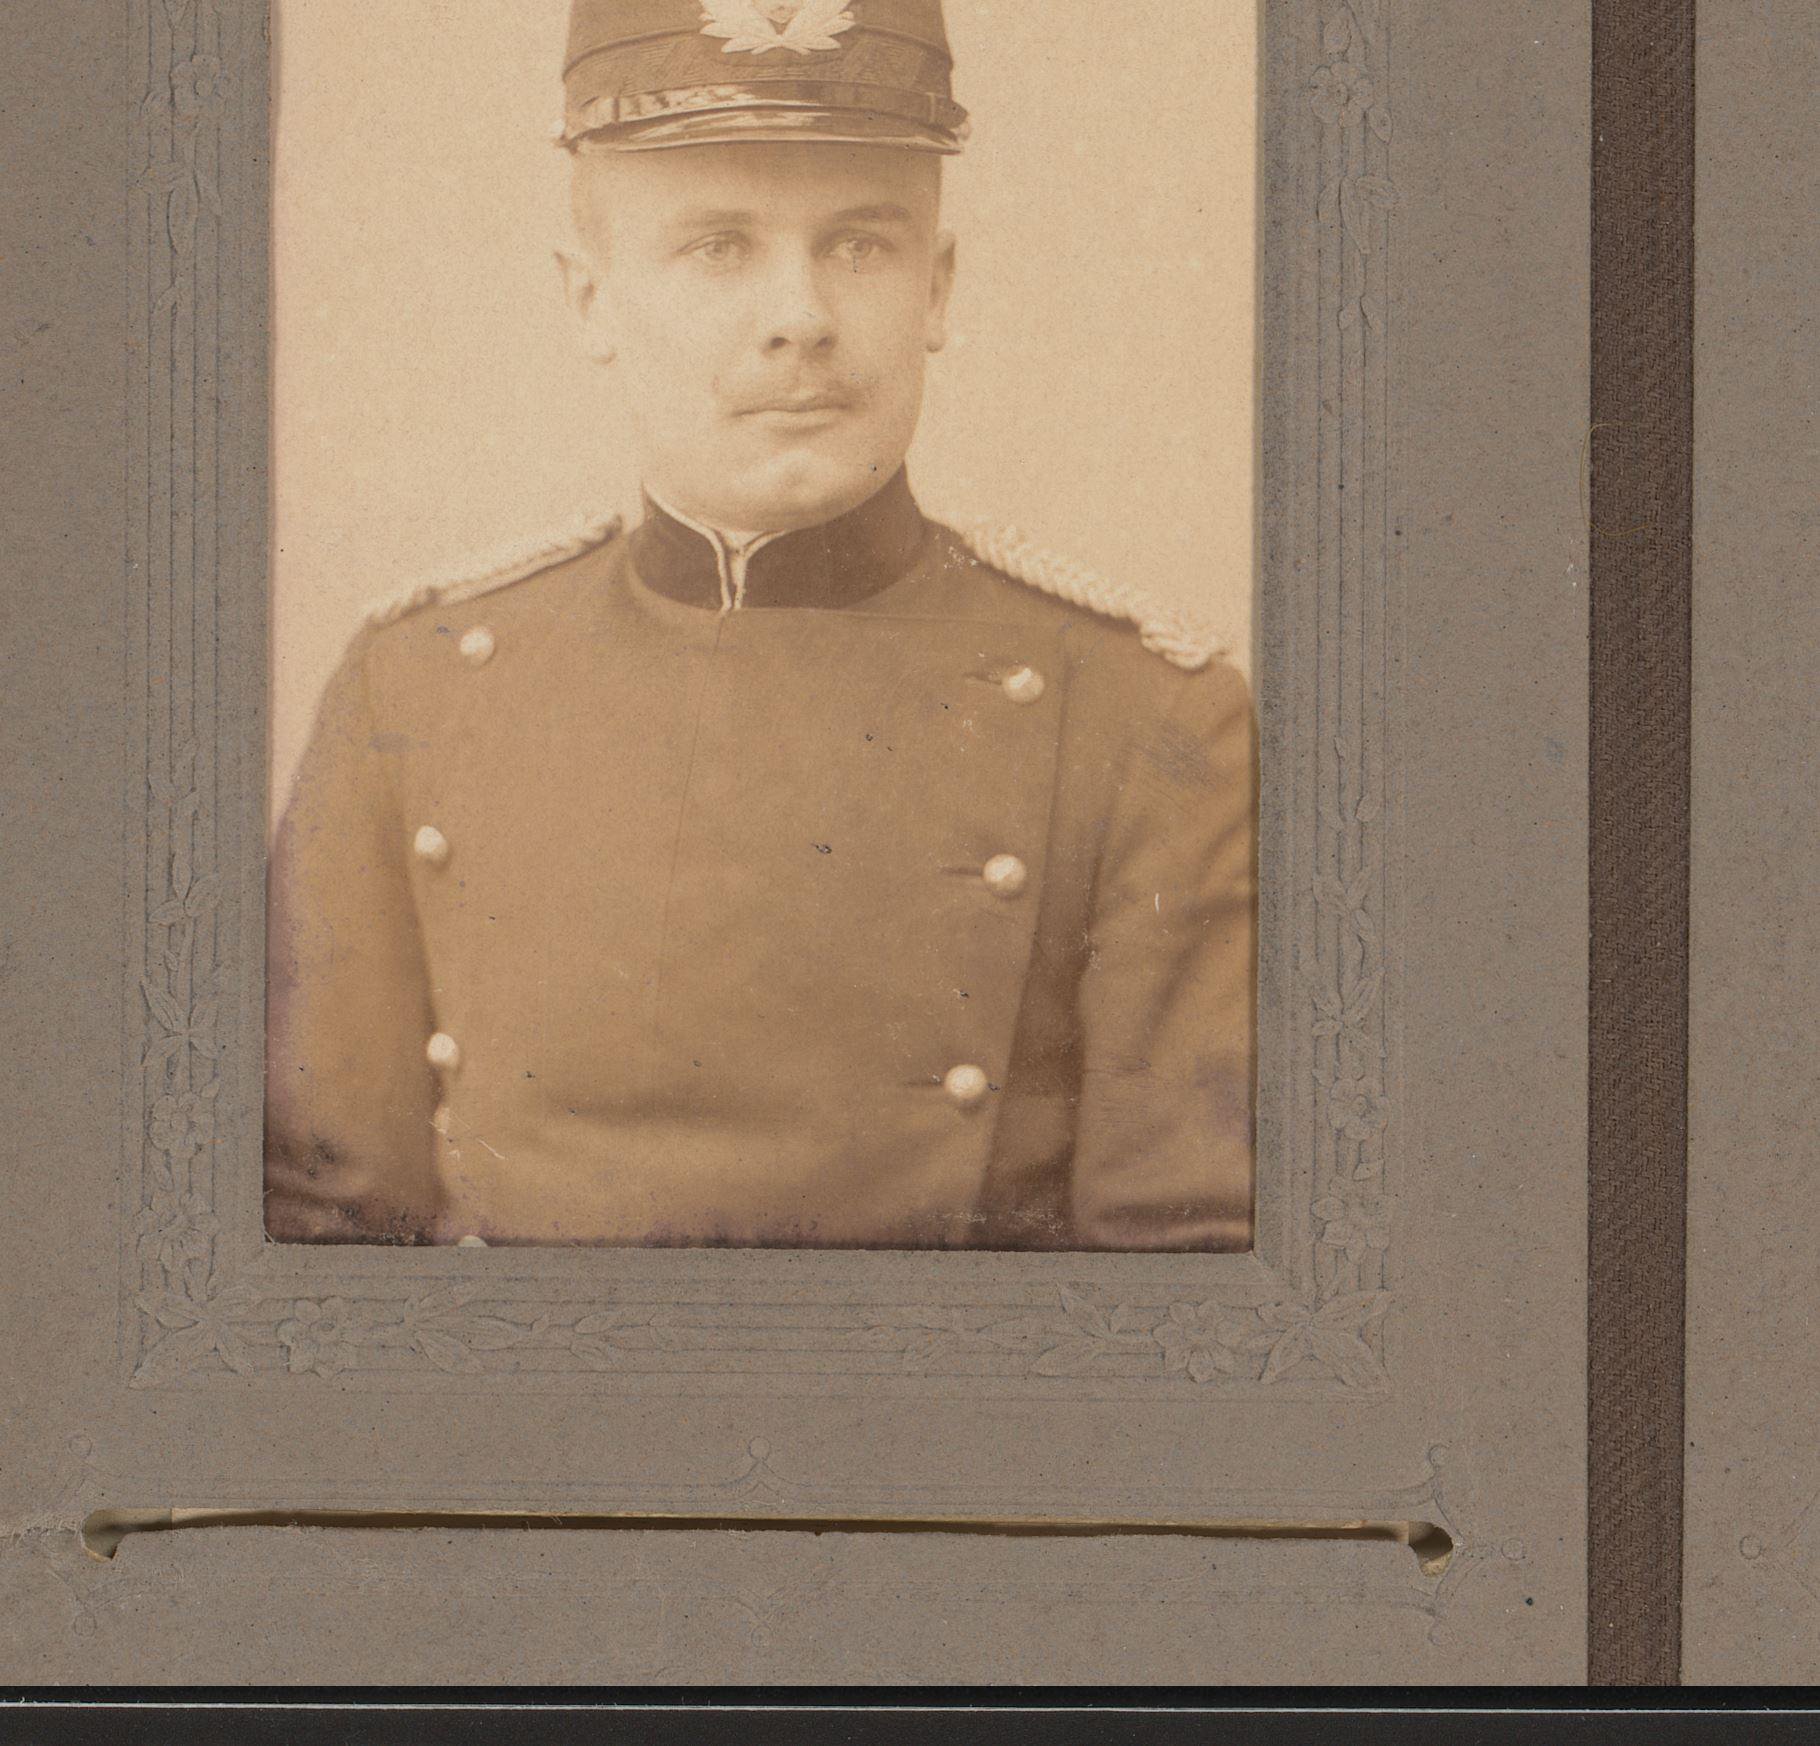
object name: album leaf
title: Portret van een man in militair uniform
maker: charles henri schouten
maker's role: fotograaf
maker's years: 1871-1941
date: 1898-1940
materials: cardboard, photographic support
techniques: collodion silver print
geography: the hague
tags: historical persons, (military) uniforms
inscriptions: inscription: ‘Charles Schouten/ den Haag/ Piet Hein Str. 23.’